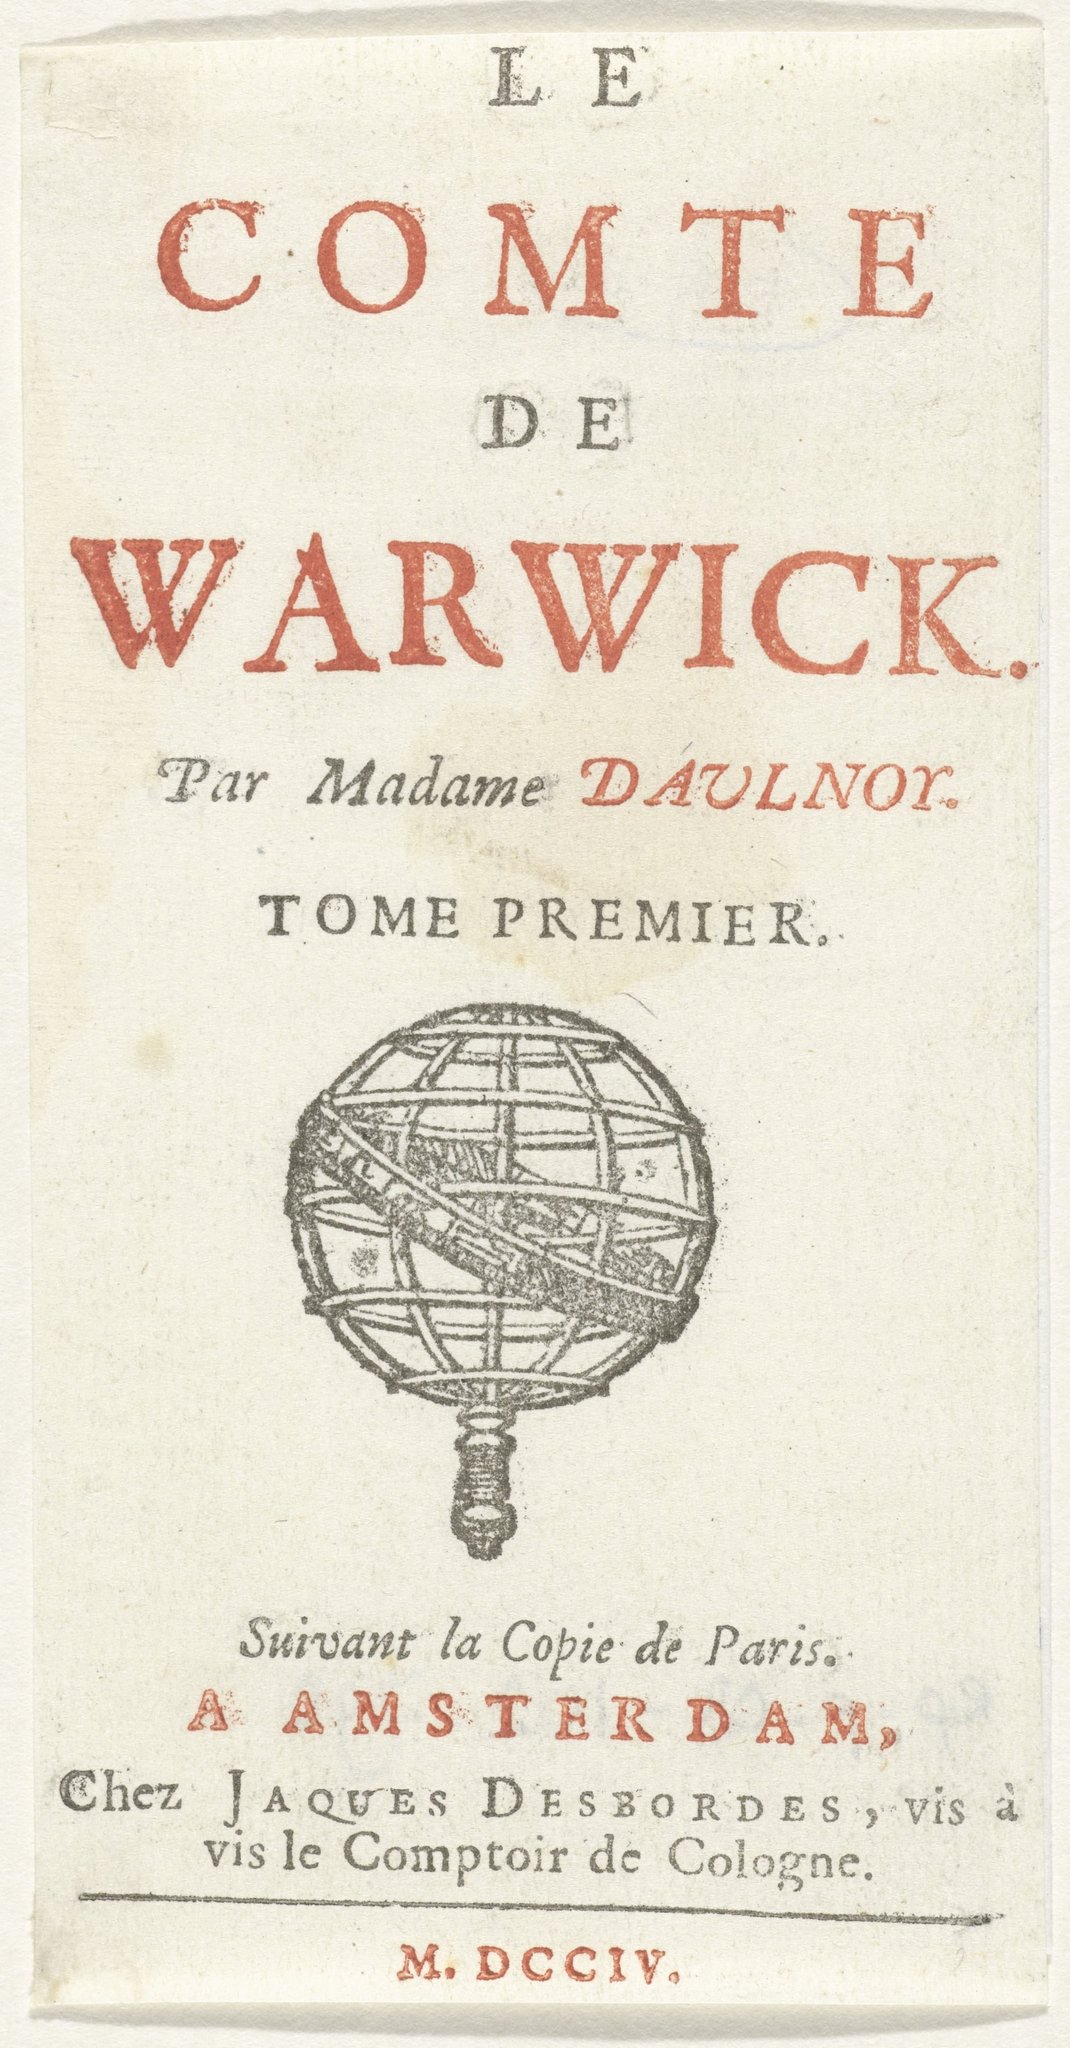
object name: titelblad, titelpagina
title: Titelpagina voor: M. D'Aulnoy, Le comte de Warwick, 1704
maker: jacques desbordes (i)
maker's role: publisher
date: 1704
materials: paper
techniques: letterpress printing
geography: amsterdam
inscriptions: collector's mark: Lugt 2228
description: Titelpagina voor het eerste deel van: Aulnoy, Marie Cathérine Le Jumel de Barneville d' (comtesse). Le comte de Warwick. Amsterdam: Jacques Desbordes (I), 1704.